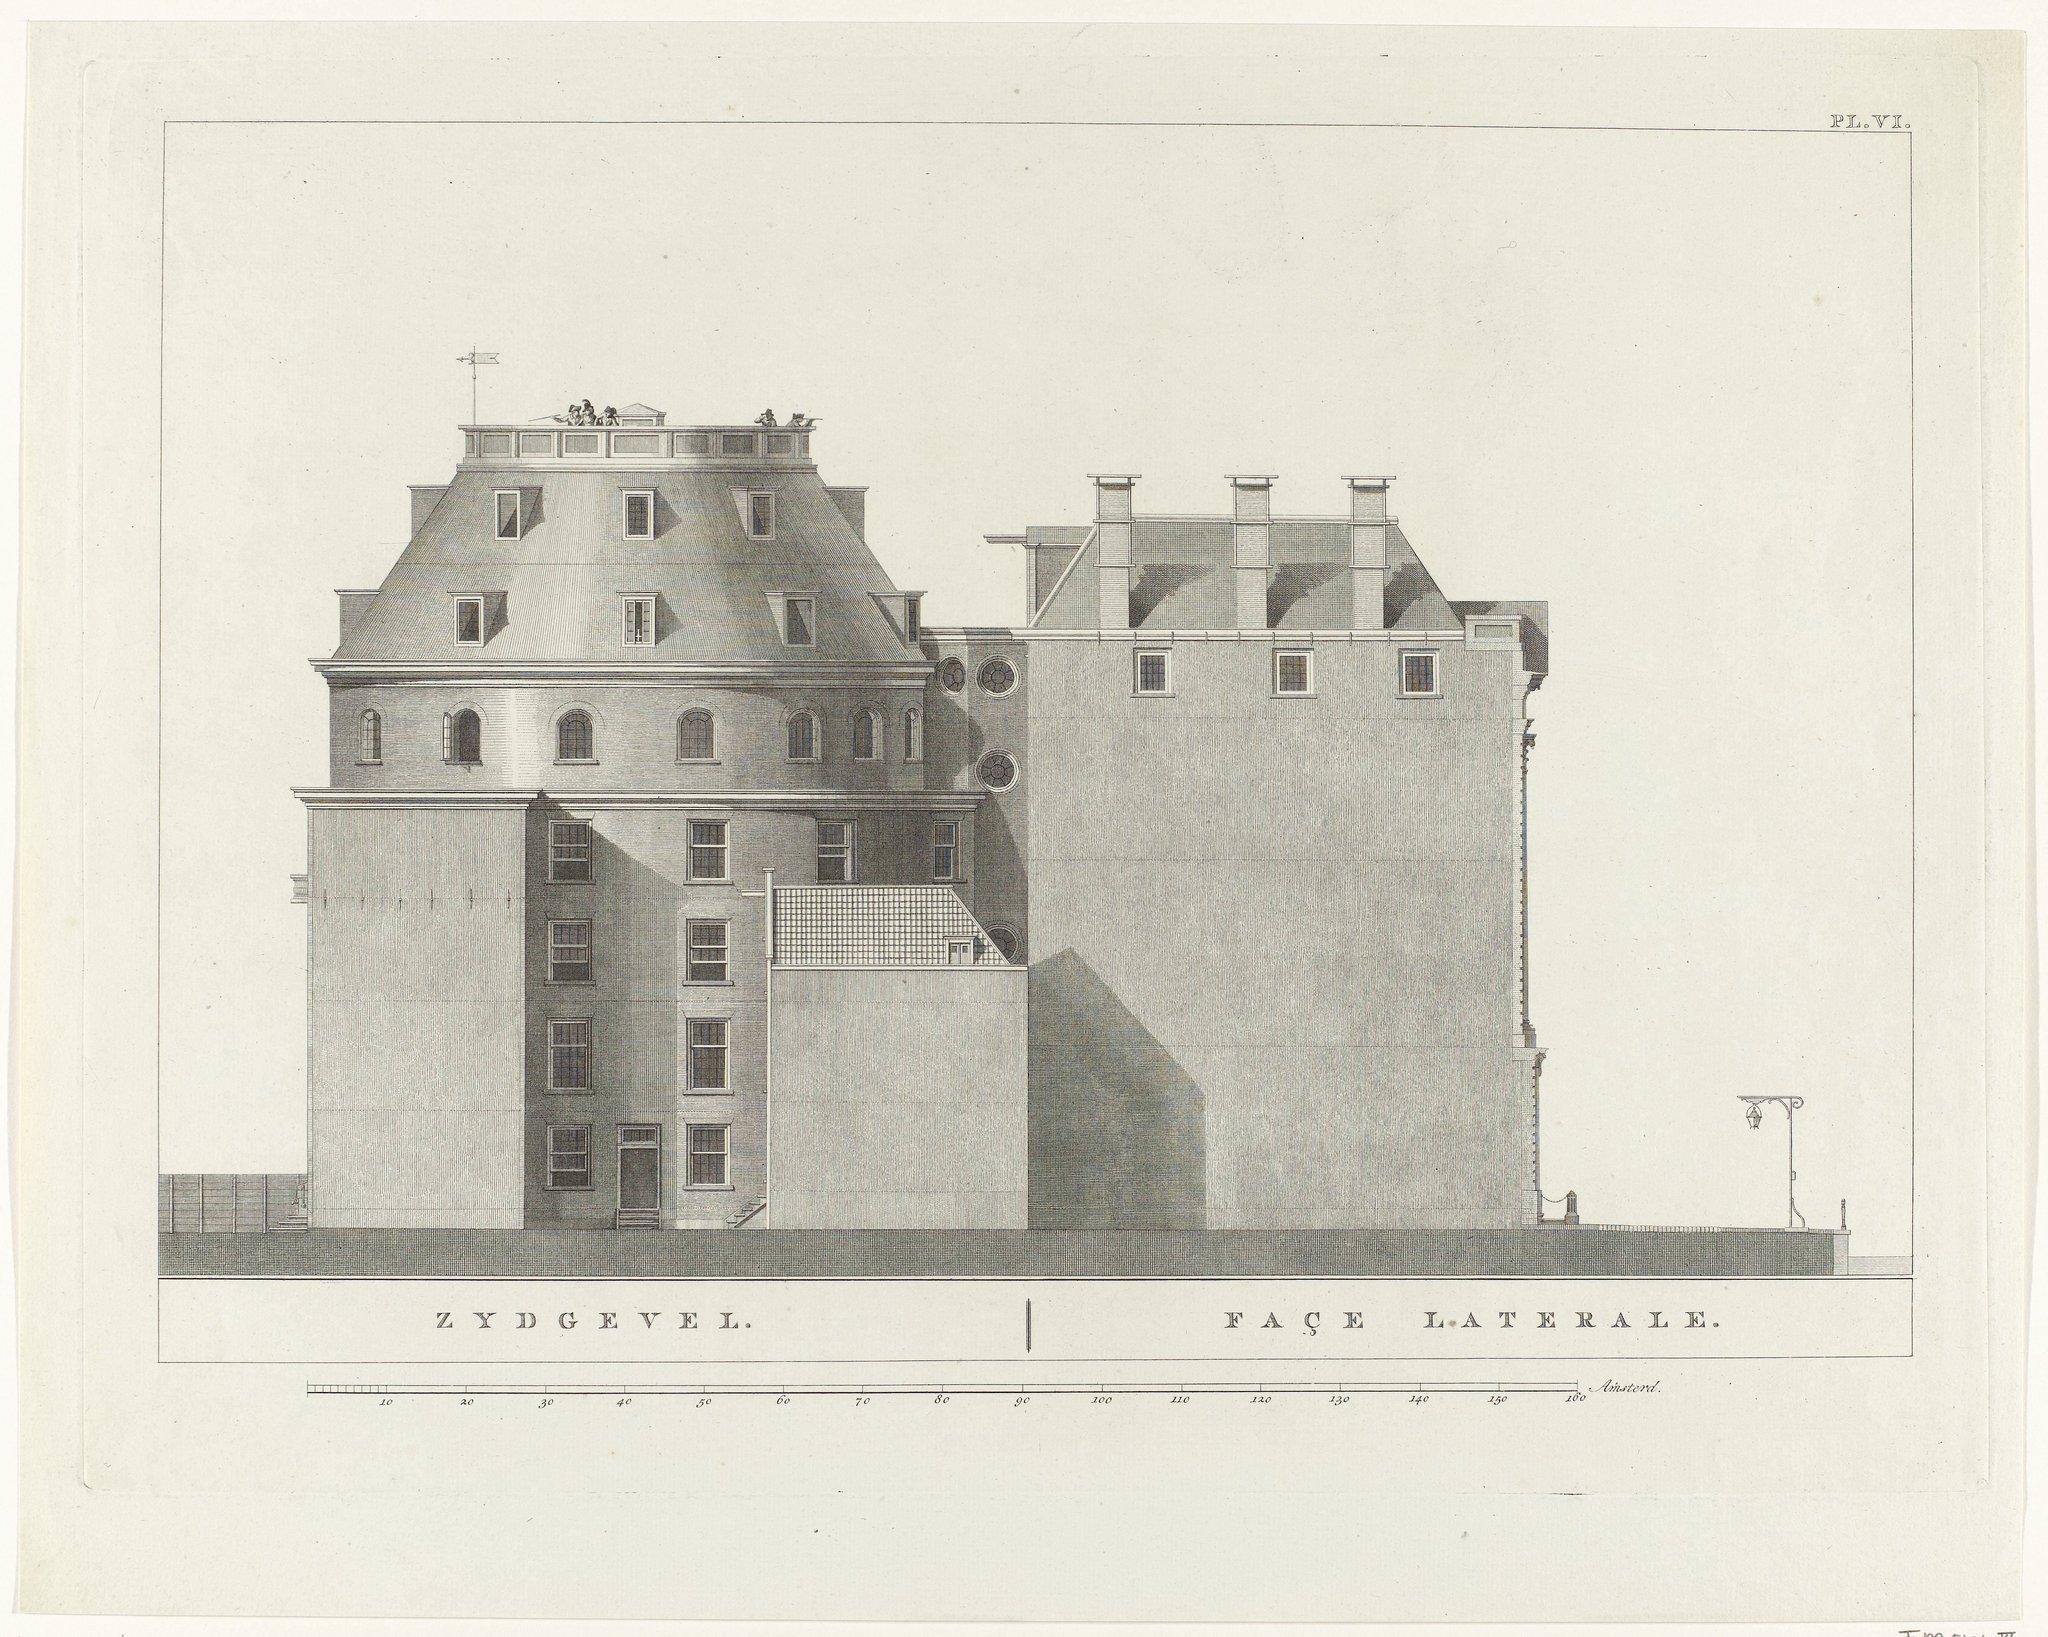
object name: print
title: Zydgevel / Façe laterale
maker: noach van der meer (ii)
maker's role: draughtsman, print maker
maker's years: 1741-1822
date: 1789-1791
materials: paper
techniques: etching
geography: amsterdam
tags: jacob otten huslij, architectural design or model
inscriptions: collector's mark: Lugt 2233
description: Zijgevel van gebouw Felix Meritis te Amsterdam. Rechtsboven genummerd: Pl. VI. Onderdeel van het plaatwerk over de architectuur van het gebouw voor de maatschappij Felix Meritis te Amsterdam, ontworpen door de achitect Jacob Otten Huslij en ingewijd op 31 oktober 1788.